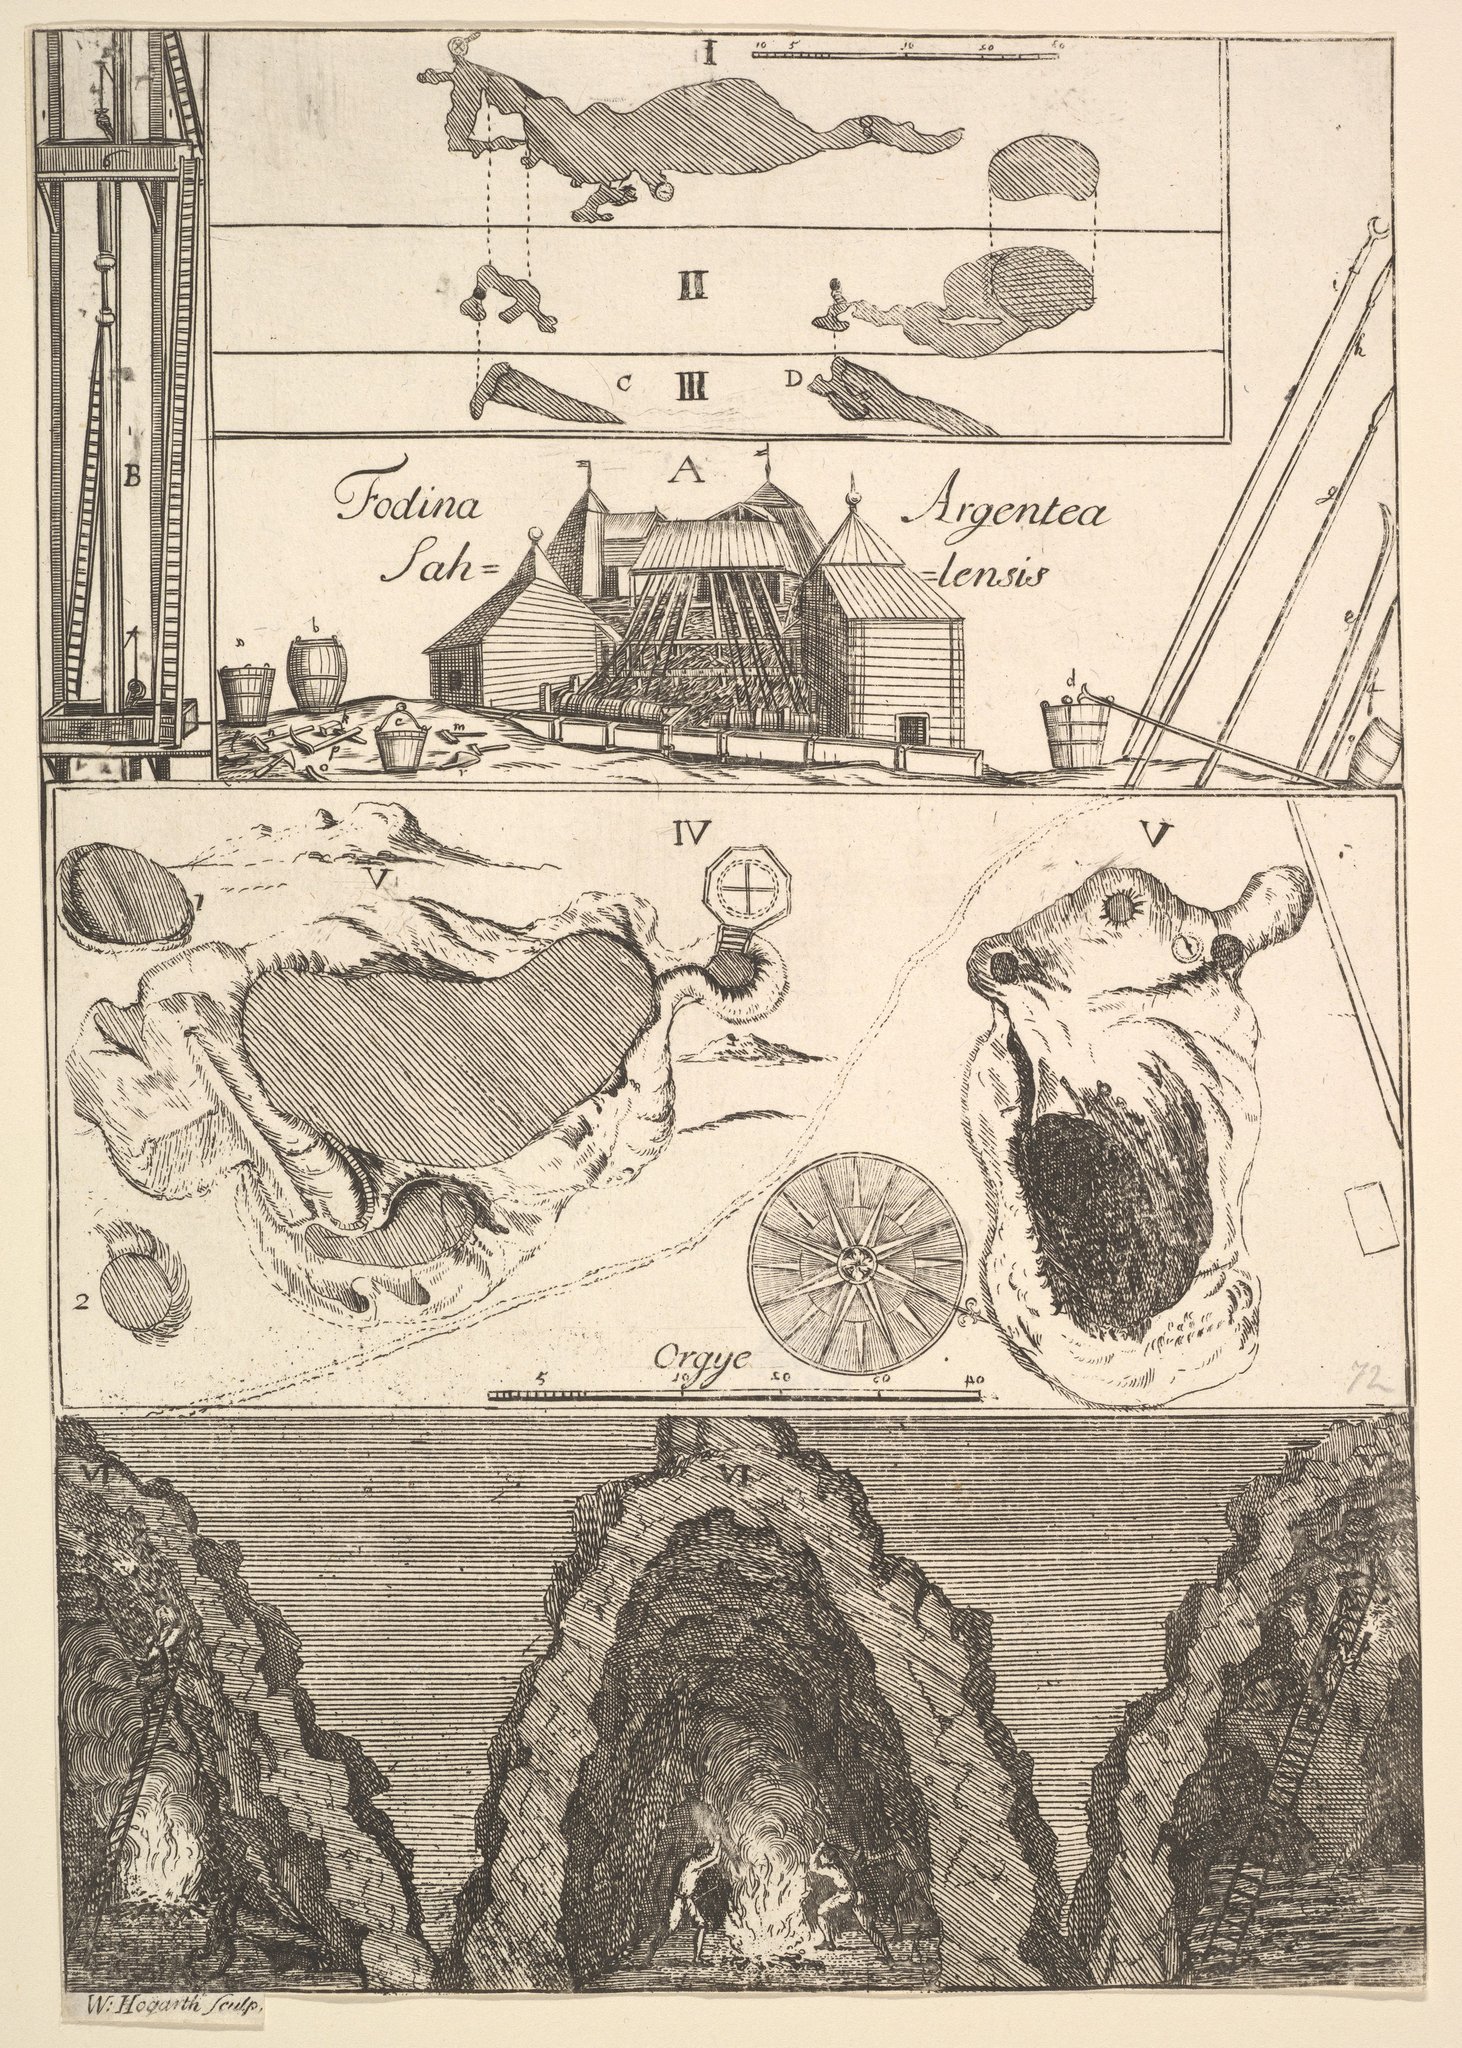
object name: print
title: Fodina argentea Sahlensis – A Silver Mine at Sala - I (from Aubry de La Mottraye's "Travels throughout Europe, Asia and into Part of Africa...," London, 1724, vol. II, pl. 33, no. 1)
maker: william hogarth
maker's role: artist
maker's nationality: british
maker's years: 1697-1764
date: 1723-1724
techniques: engraving, etching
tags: human figures,buildings,fire